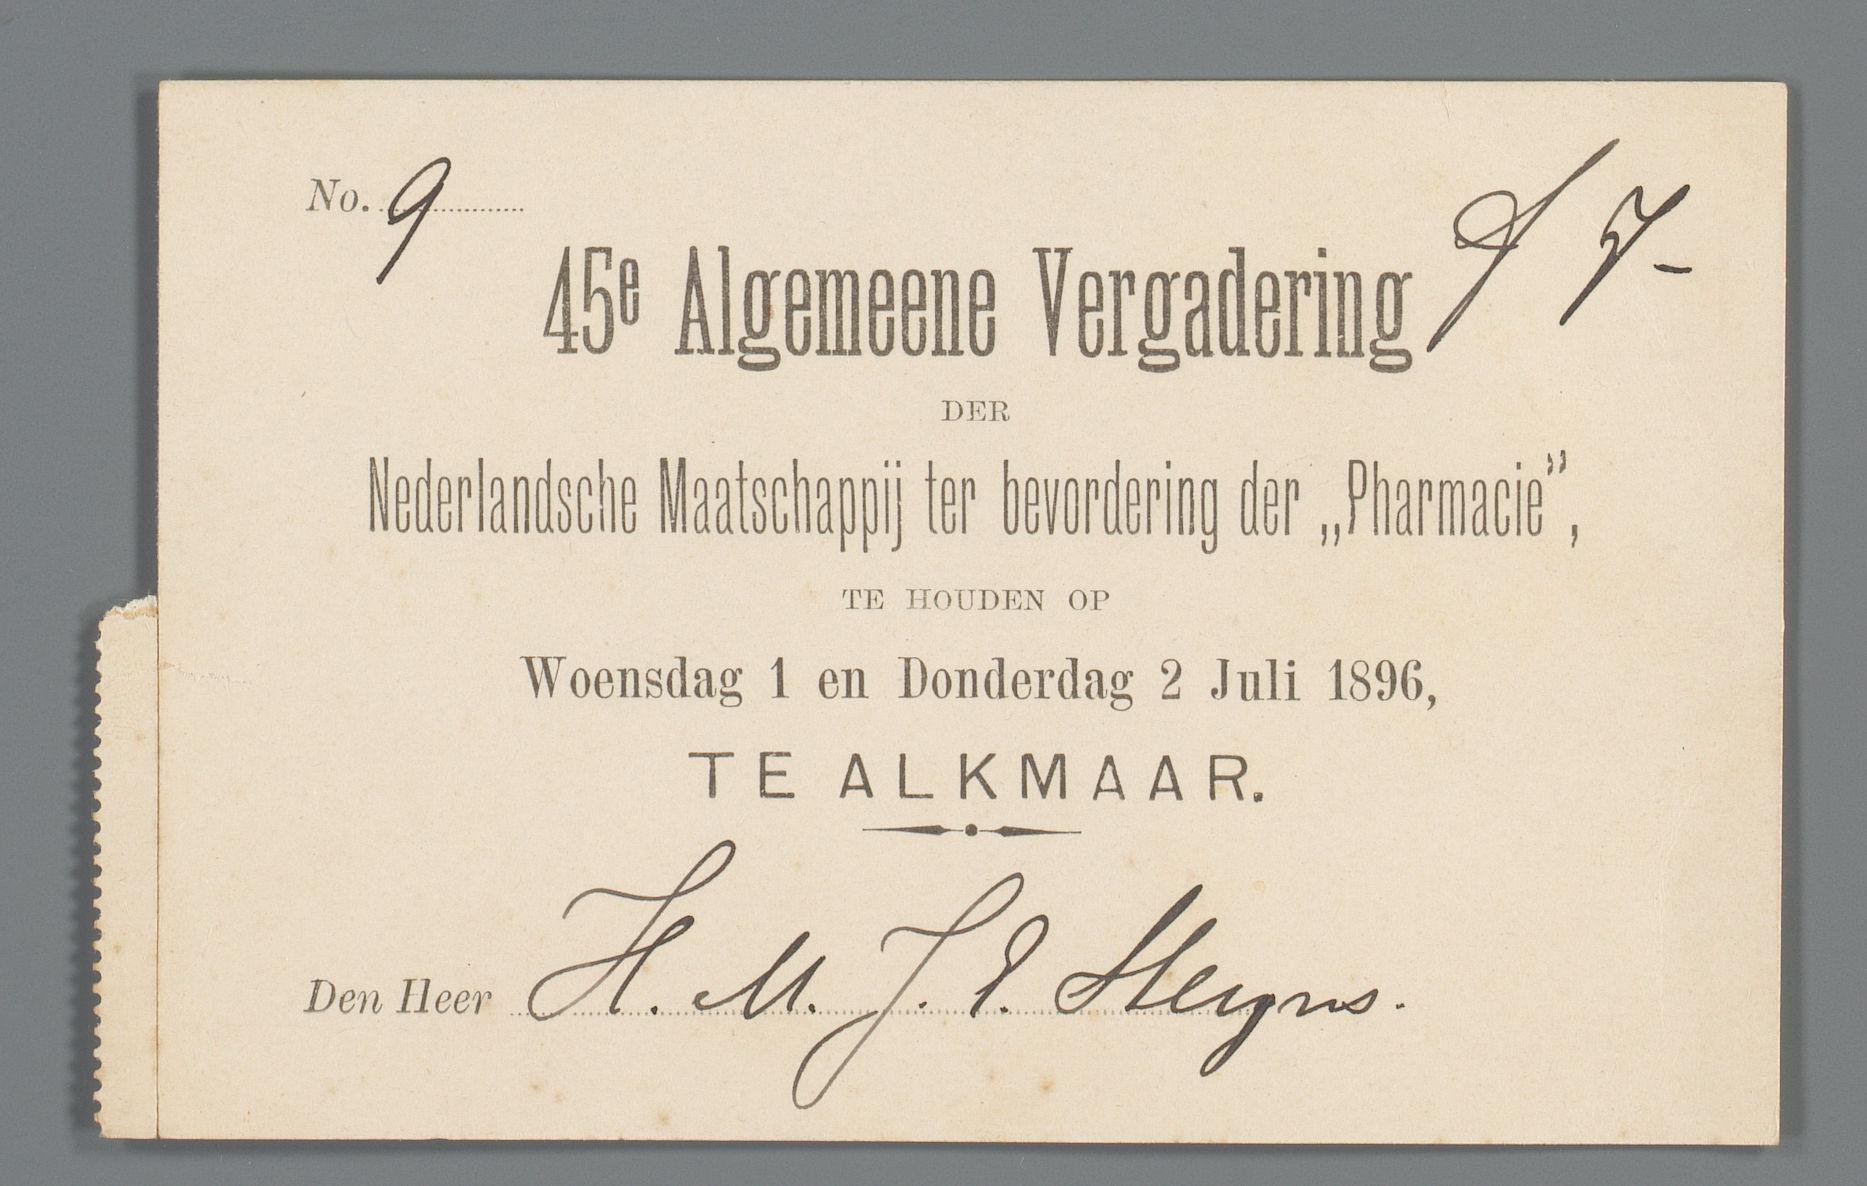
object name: photomechanical print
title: Uitnodiging voor de '45e Algemeene Vergadering der Nederlandsche Maatschappij ter bevordering der 'Pharmacie'' in 1896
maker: Anonymous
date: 1896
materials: paper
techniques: printing block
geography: the hague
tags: fancy letters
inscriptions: date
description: Typografische kaart met de tekst: '45e Algemeene Vergadering der Nederlandsche Maatschappij ter bevordering der 'Pharmacie' te houden op Woensdag 1 en Donderdag 2 Juli 1896 te Alkmaar. Den Heer', waarna een naam met de hand geschreven is. Boven deze tekst nog ruimte voor een nummer, waar het cijfer 9 is ingevuld. Rechtsboven op de kaart is 'f 7,-' geschreven.